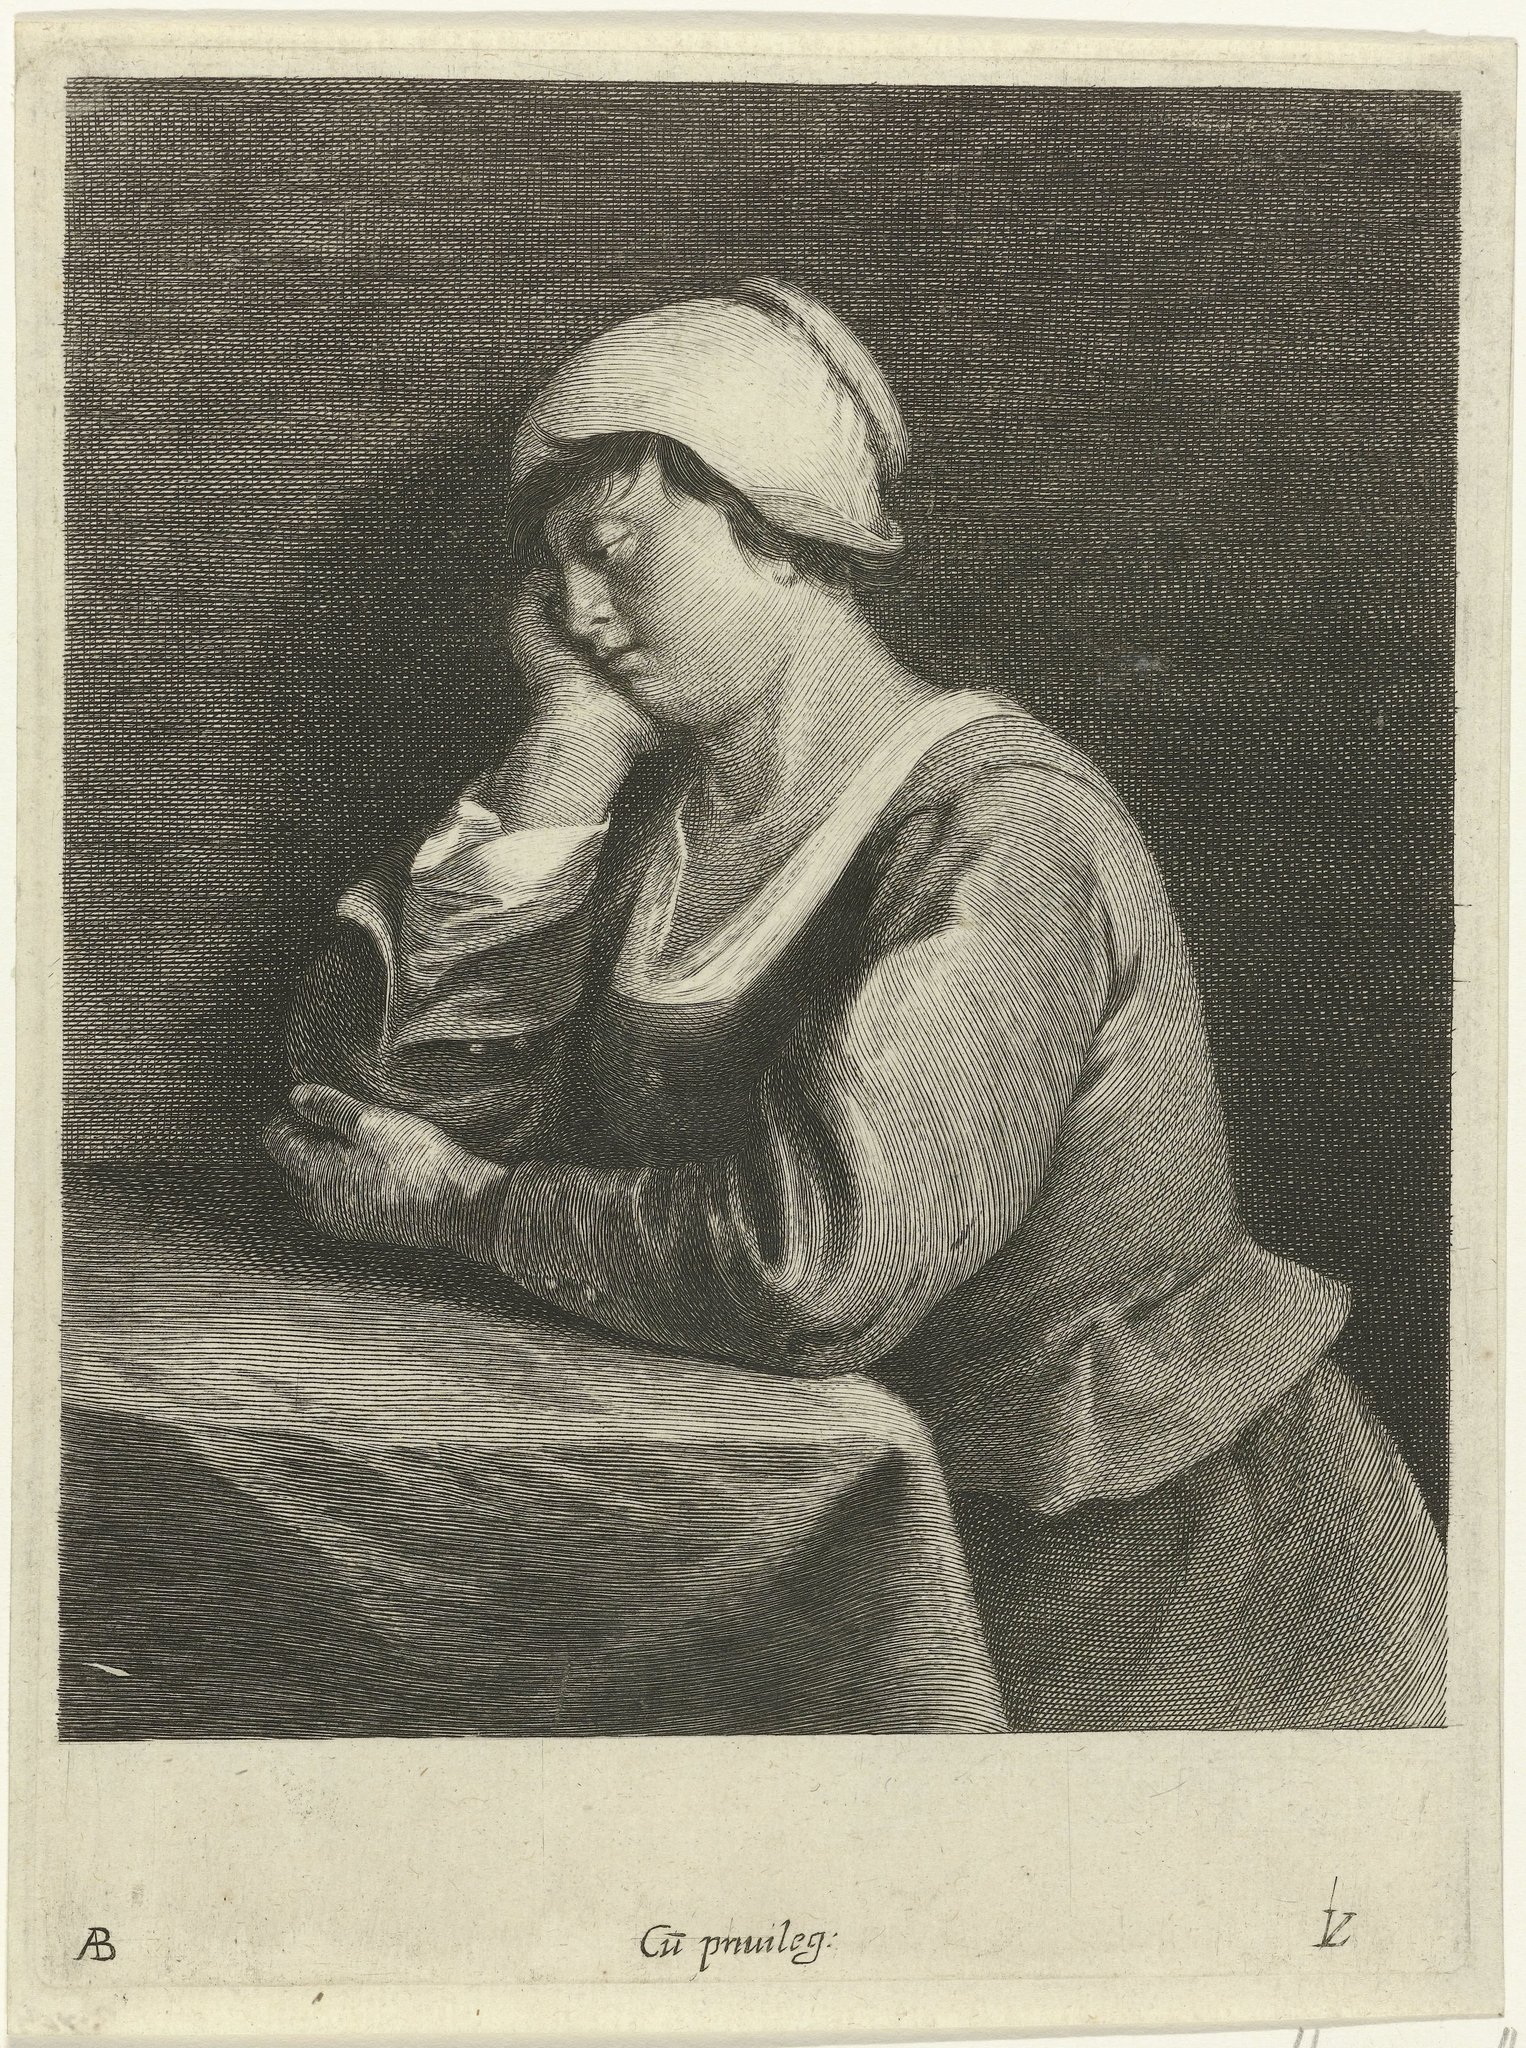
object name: print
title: Luiheid (Acedia)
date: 1619-1675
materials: paper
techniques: engraving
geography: antwerp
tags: sloth, indolence, 'acedia', 'desidia'; 'accidia' (ripa) ~ personification of one of the seven deadly sins, head held in the hand(s), with elbows leaning on an elevation or on the knees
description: Een jonge vrouw zit achter een tafel en ondersteunt met haar arm haar hoofd.